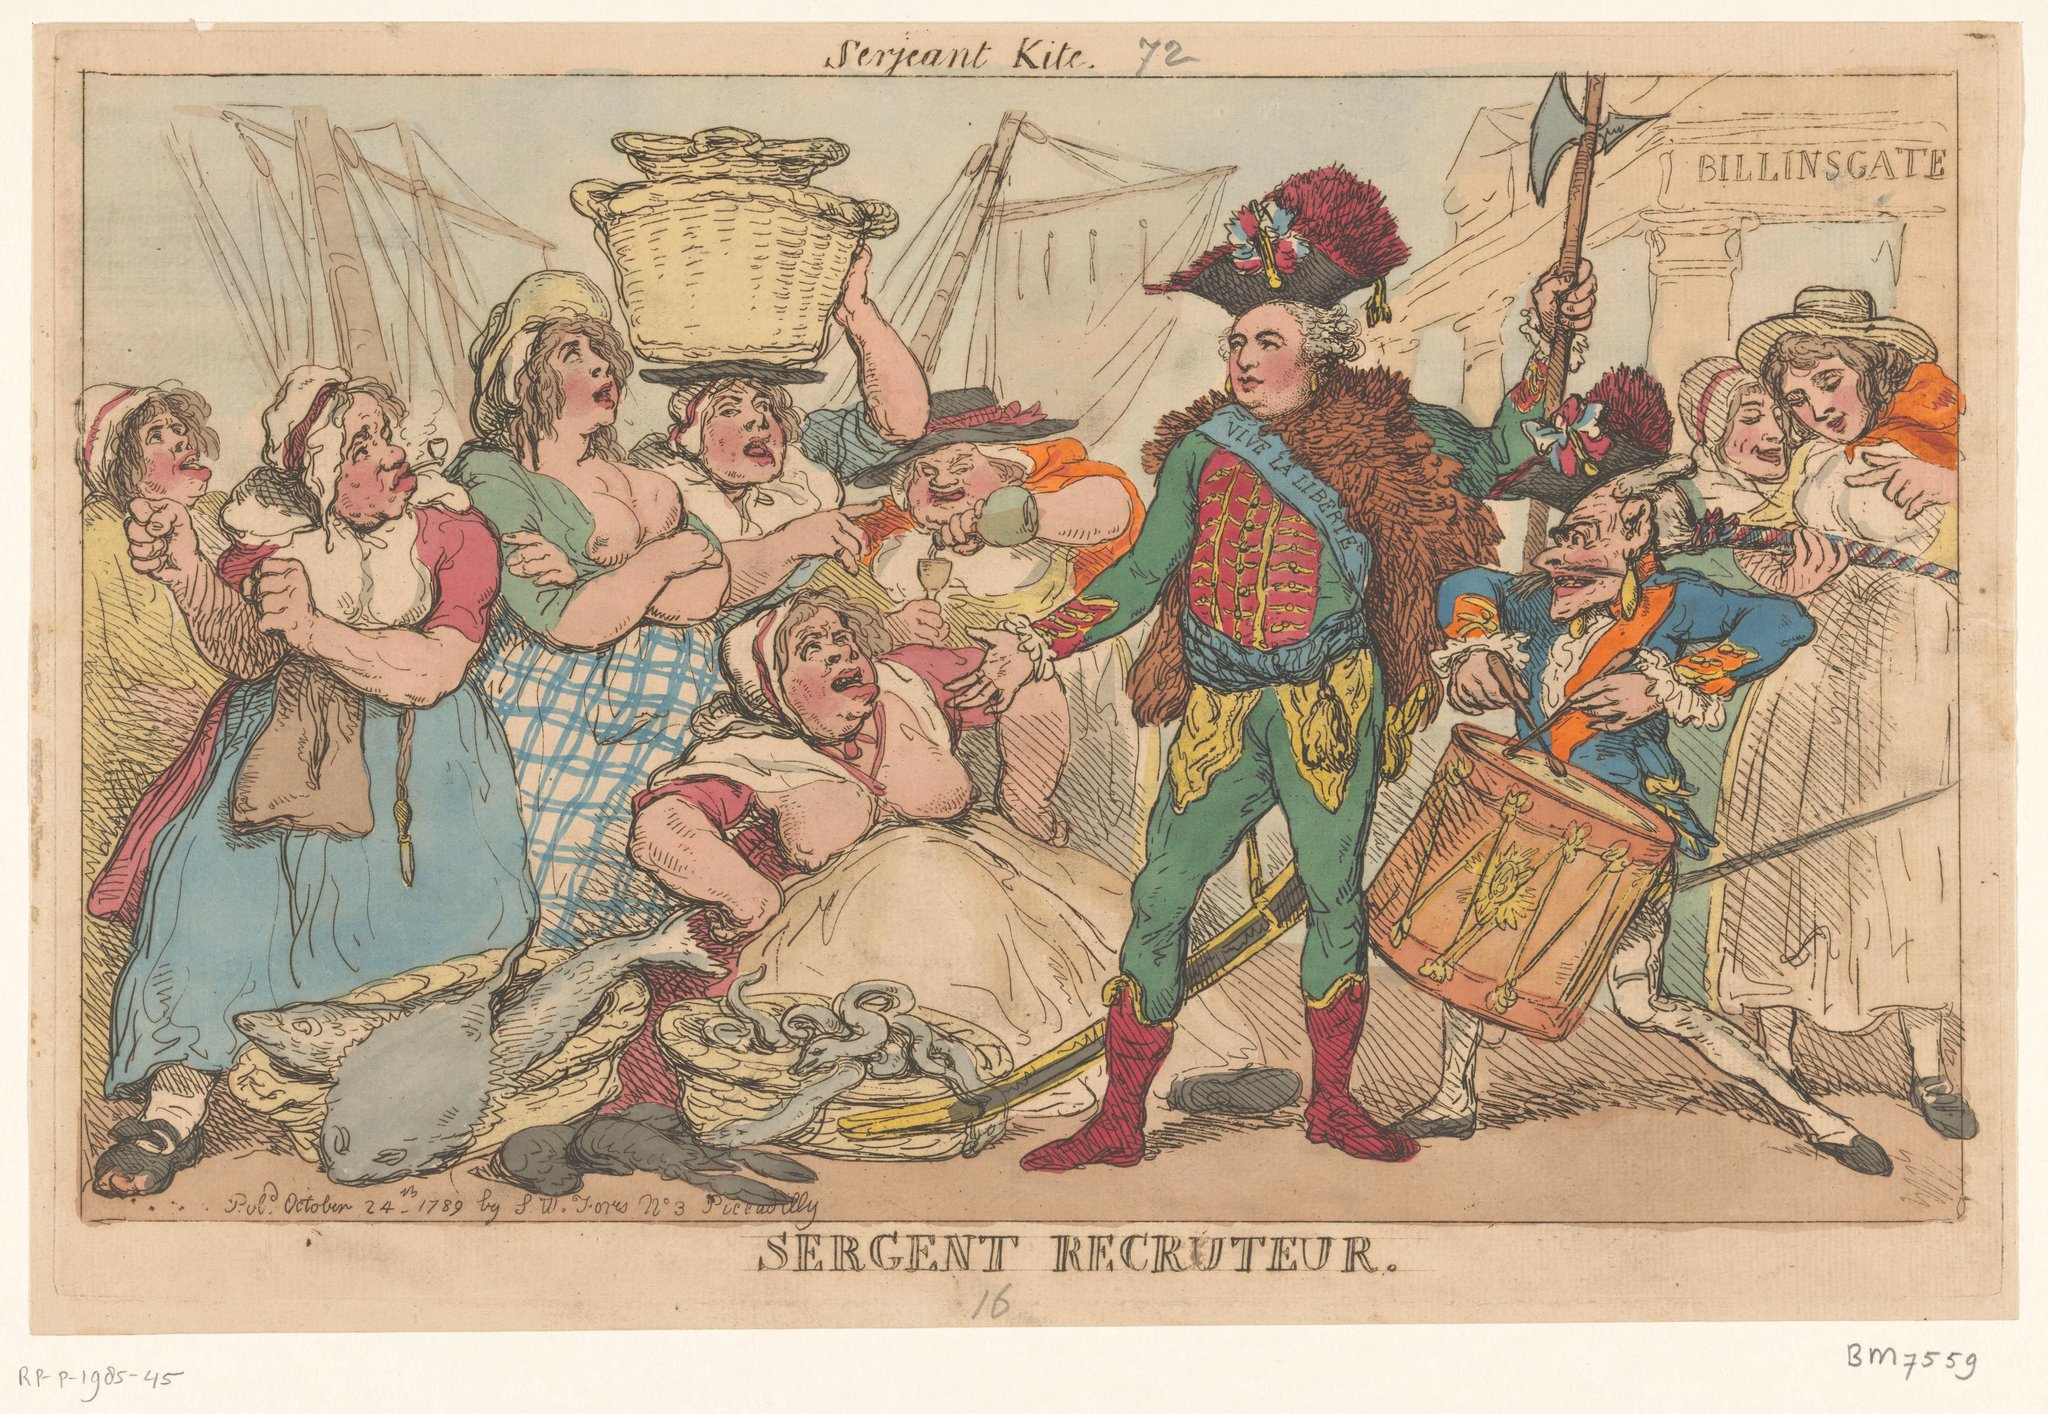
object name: print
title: Hertog van Orléans tussen de visvrouwen, 1789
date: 1789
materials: paper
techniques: etching, hand coloring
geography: london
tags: paris, lodewijk filips ii (hertog van orléans), fishes, market, sea and coastal fishery, political caricatures and satires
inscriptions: collector's mark: Lugt 2760, collector's mark: Lugt 2228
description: Spotprent waarin Lodewijk Filips II, hertog van Orléans, steun zoekt tussen de visvrouwen van de Billingsgate vismarkt, 1789. Hij wordt begeleid door een trommelaar. De vrouwen lachen hem uit en maken hem belachelijk.